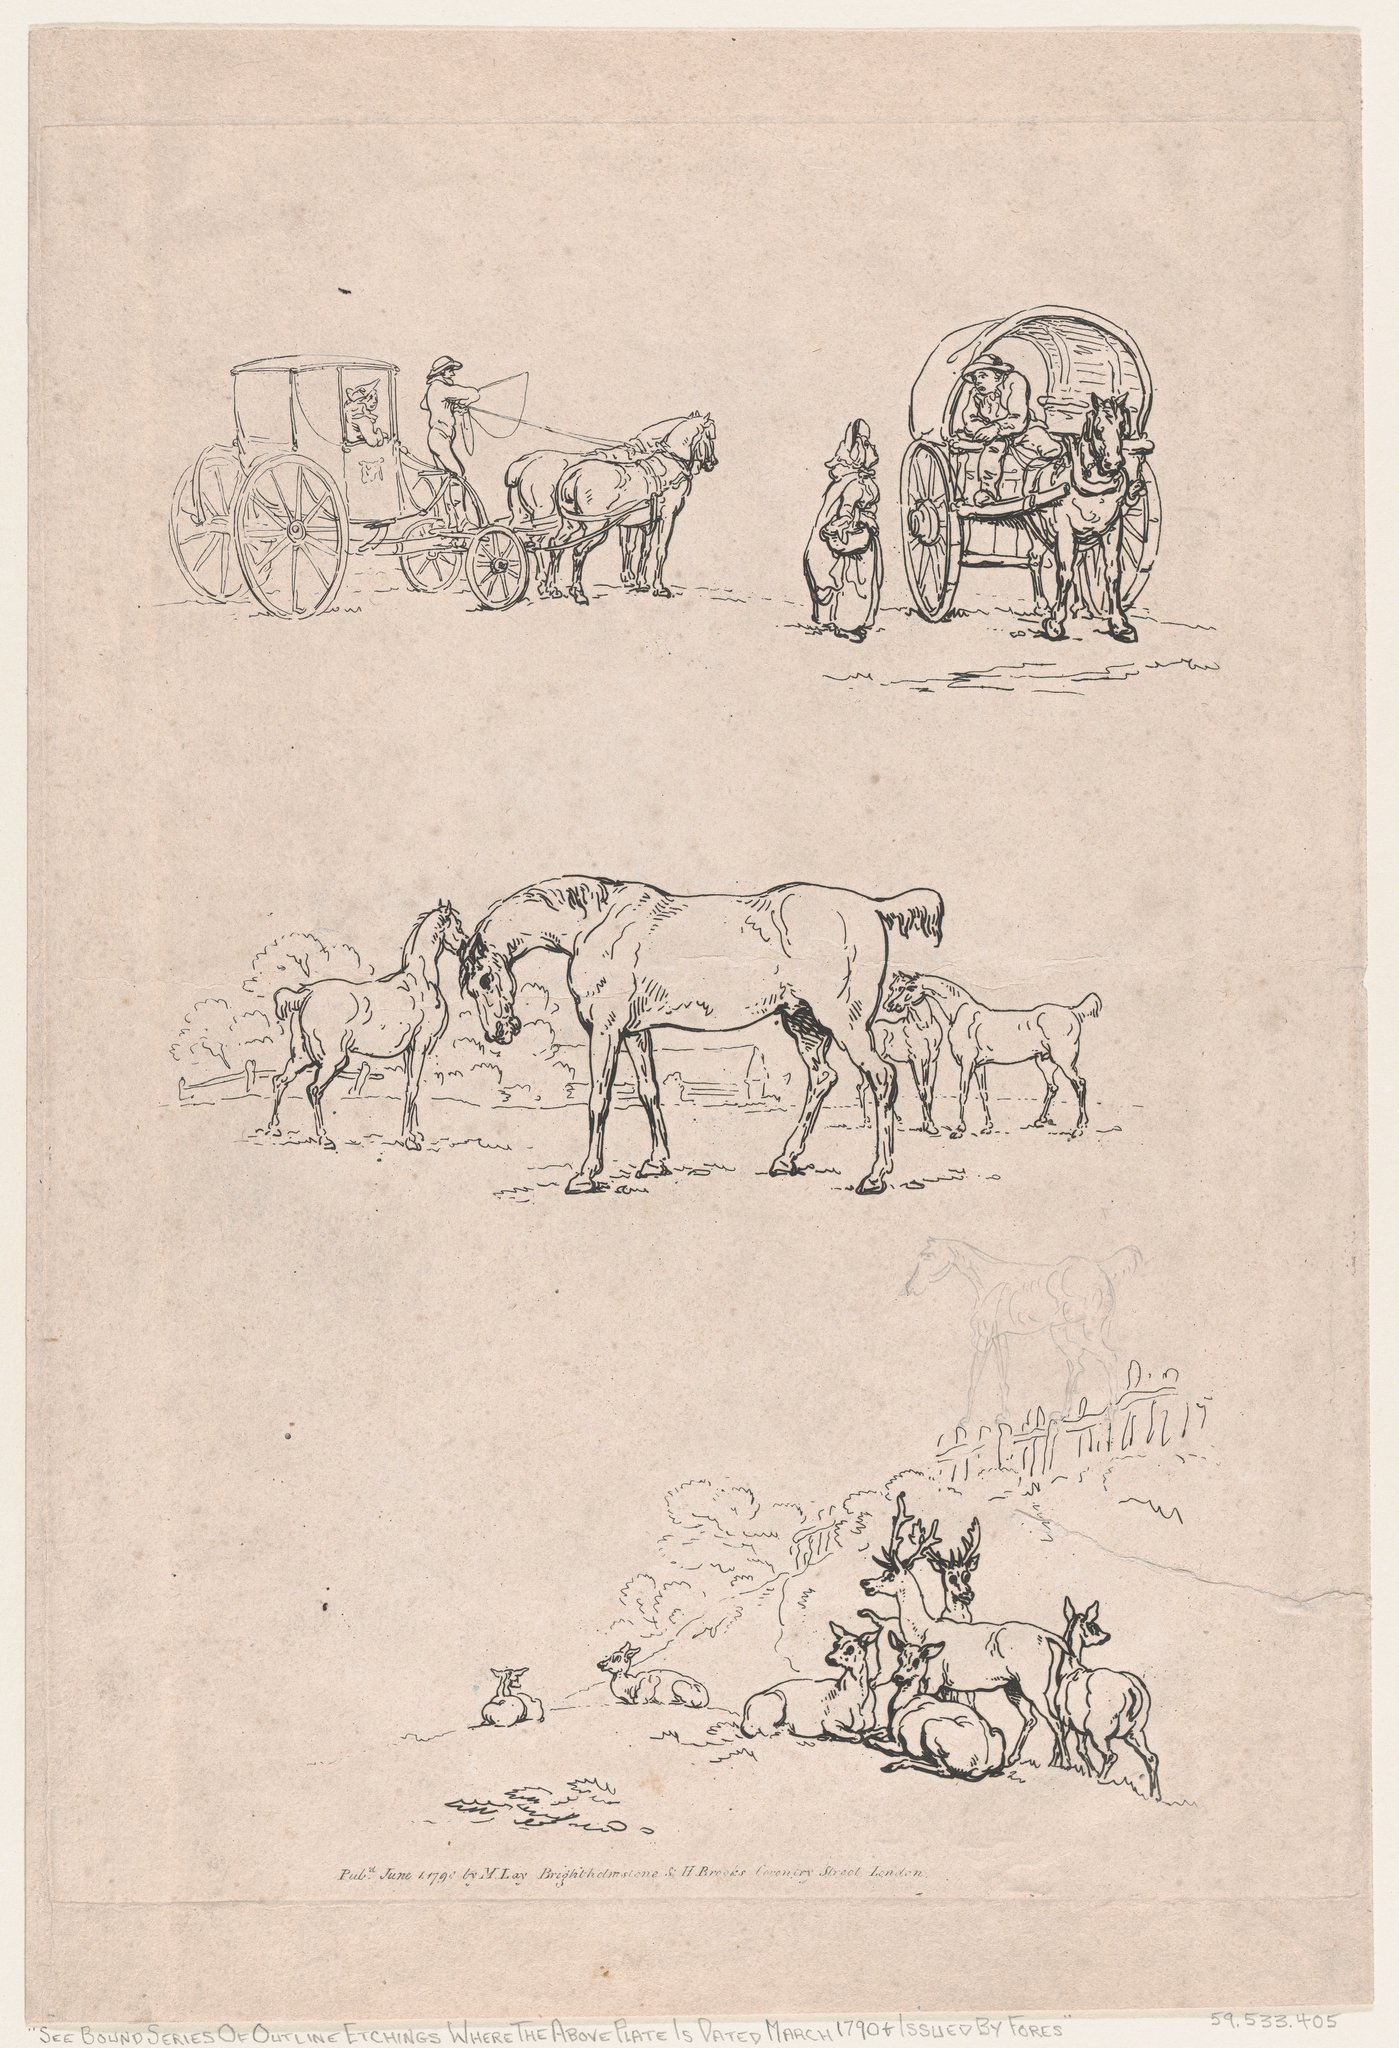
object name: print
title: Plate 3, Outlines of Figures, Landscapes and Cattle...for the Use of Learners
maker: thomas rowlandson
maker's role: artist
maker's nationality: british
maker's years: 1757-1827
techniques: etching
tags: human figures,animals,deer,horses,carriages